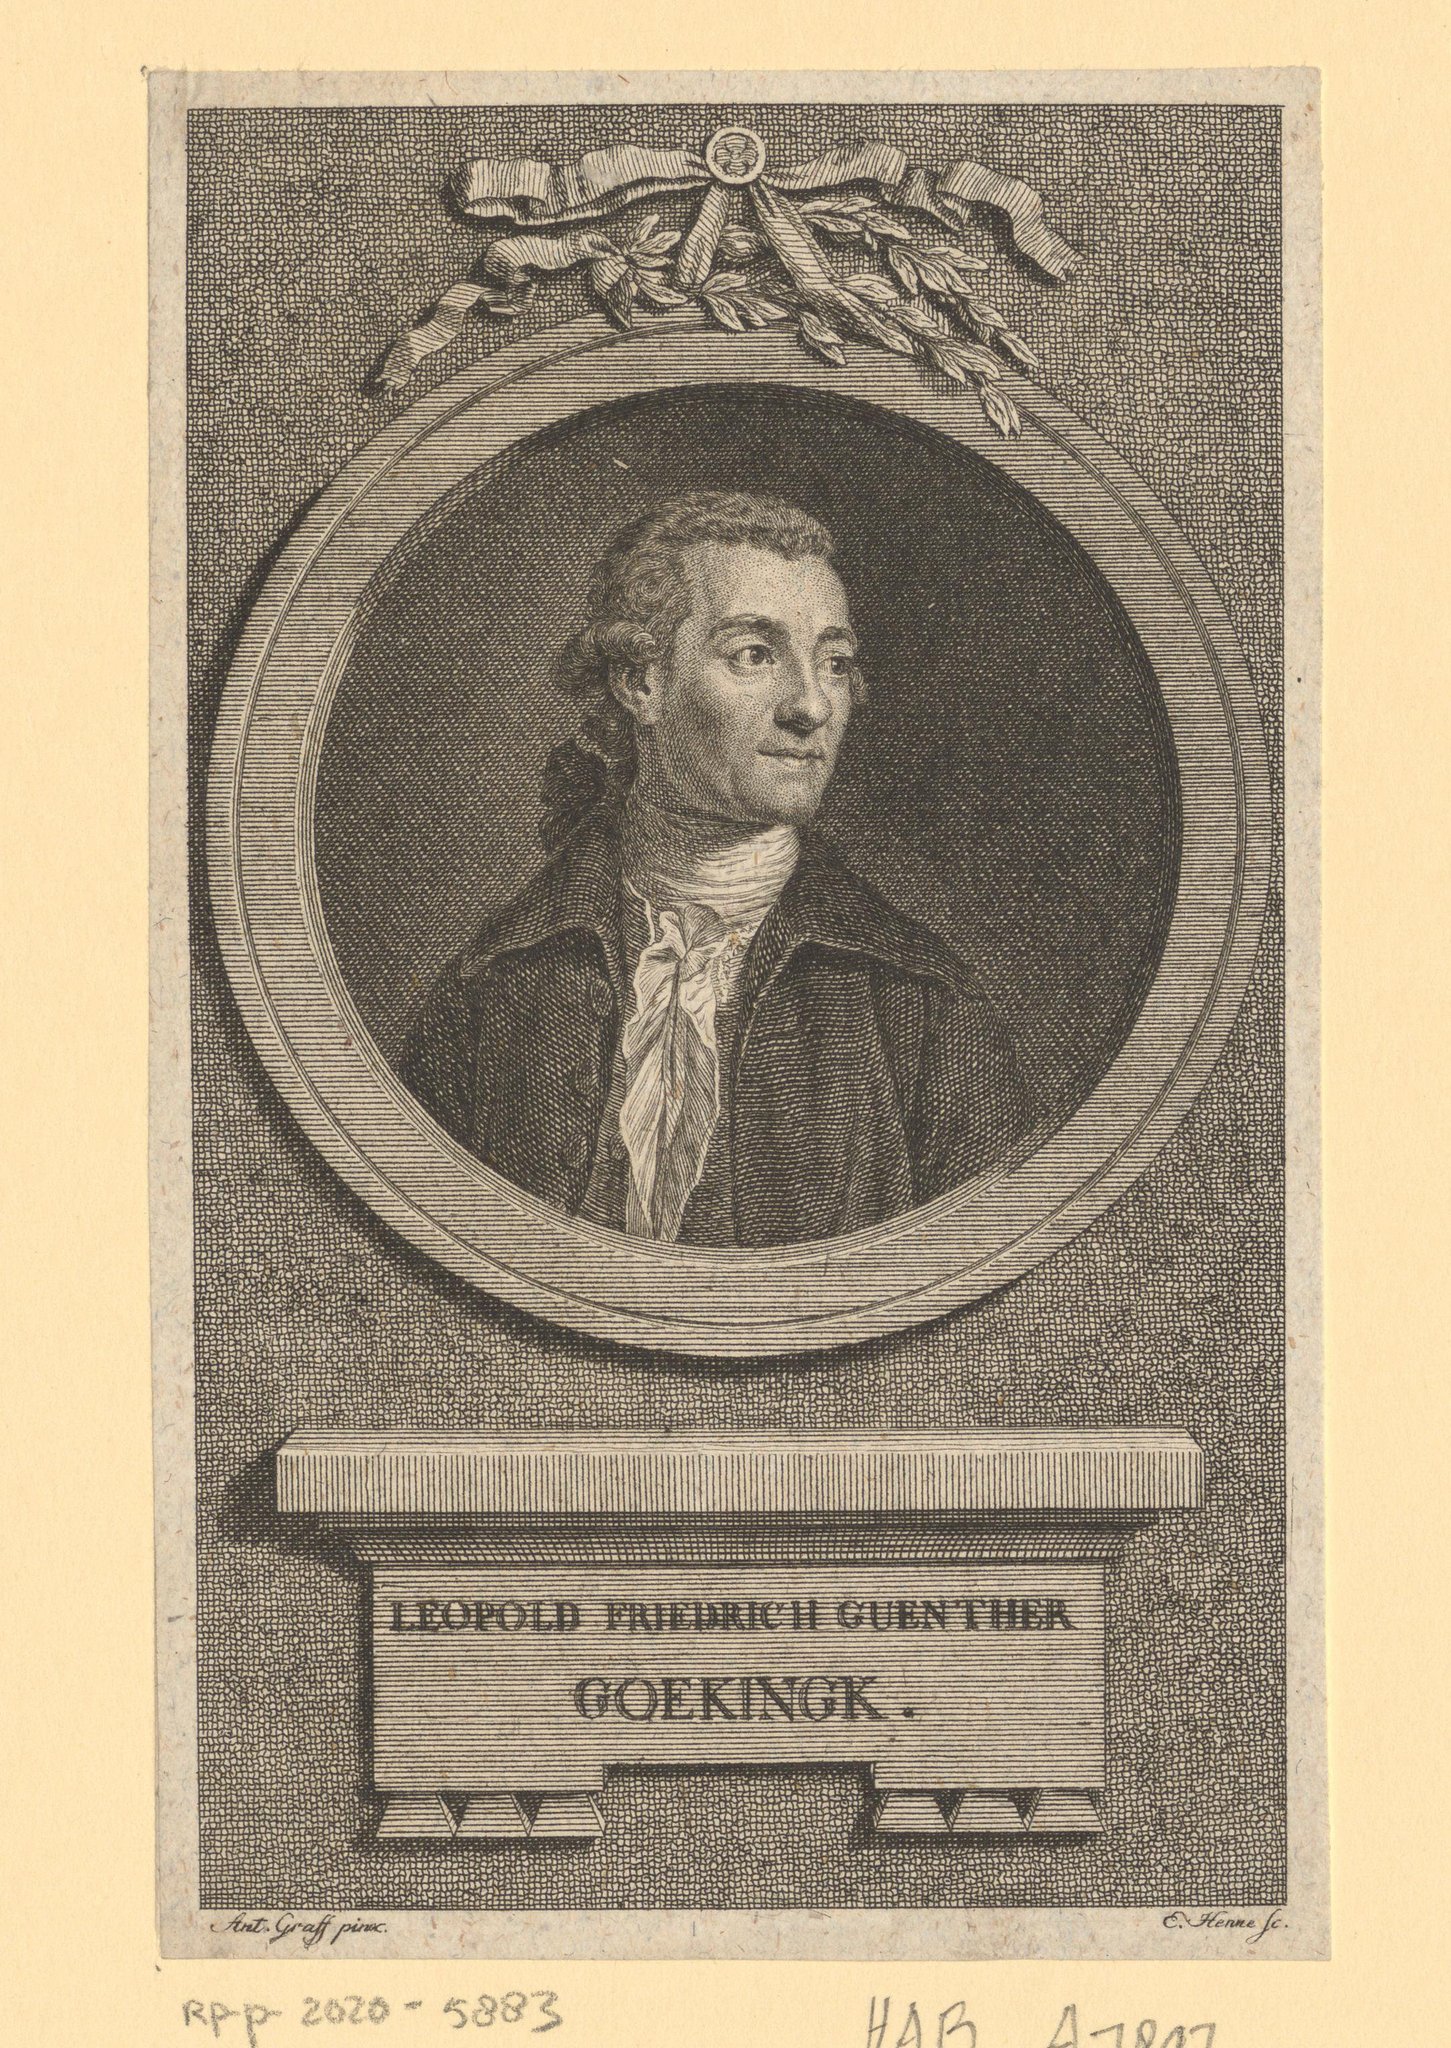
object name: print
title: Portret van Leopold Friedrich Günther Goeckingk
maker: eberhard siegfried henne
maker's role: print maker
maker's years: 1759-1828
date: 1786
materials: paper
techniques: engraving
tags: trees: laurel (branch, stick), ornament ~ medallion, historical persons, writer, poet, author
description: Prent mogelijk uit: Allgemeine deutsche Bibliothek. Berlijn en Stettin: Friedrich Nicolai, 1786, dl. 65.